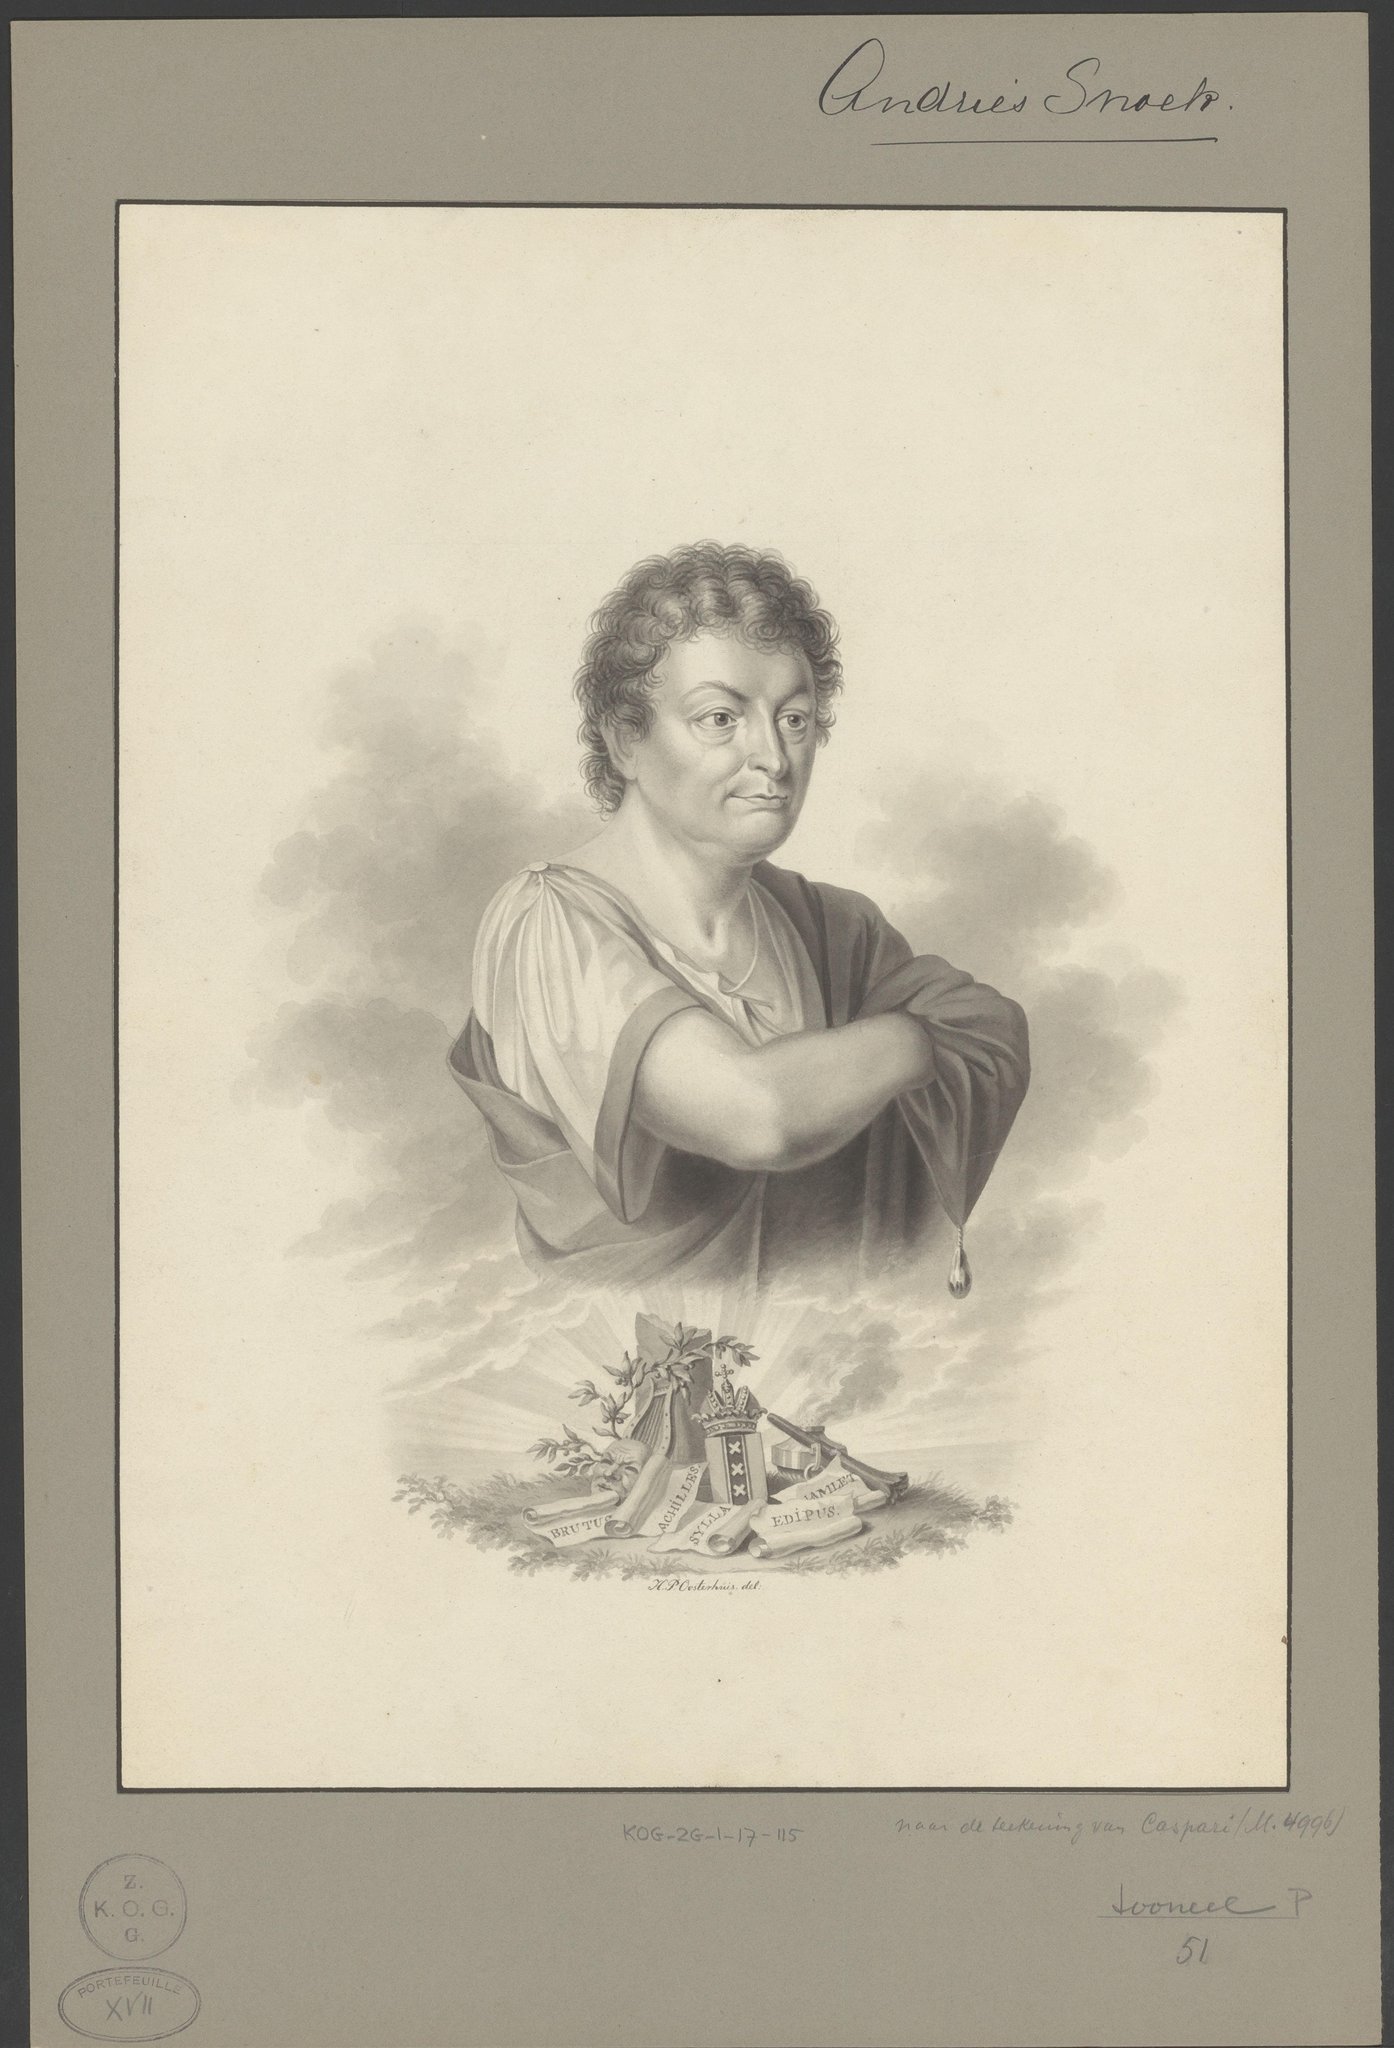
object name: drawing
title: Portret van Andreas Snoek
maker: haatje pieters oosterhuis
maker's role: draughtsman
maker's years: 1784-1854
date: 1795-1854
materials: ink, paper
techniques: brush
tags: historical persons, portrait of actor, actress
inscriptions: stamp, collector's mark: Lugt 1641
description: Onderwerpsrubrieken binnen de Atlas Zeden en Gewoonten: Tooneel, Portretten van toneelspelers.